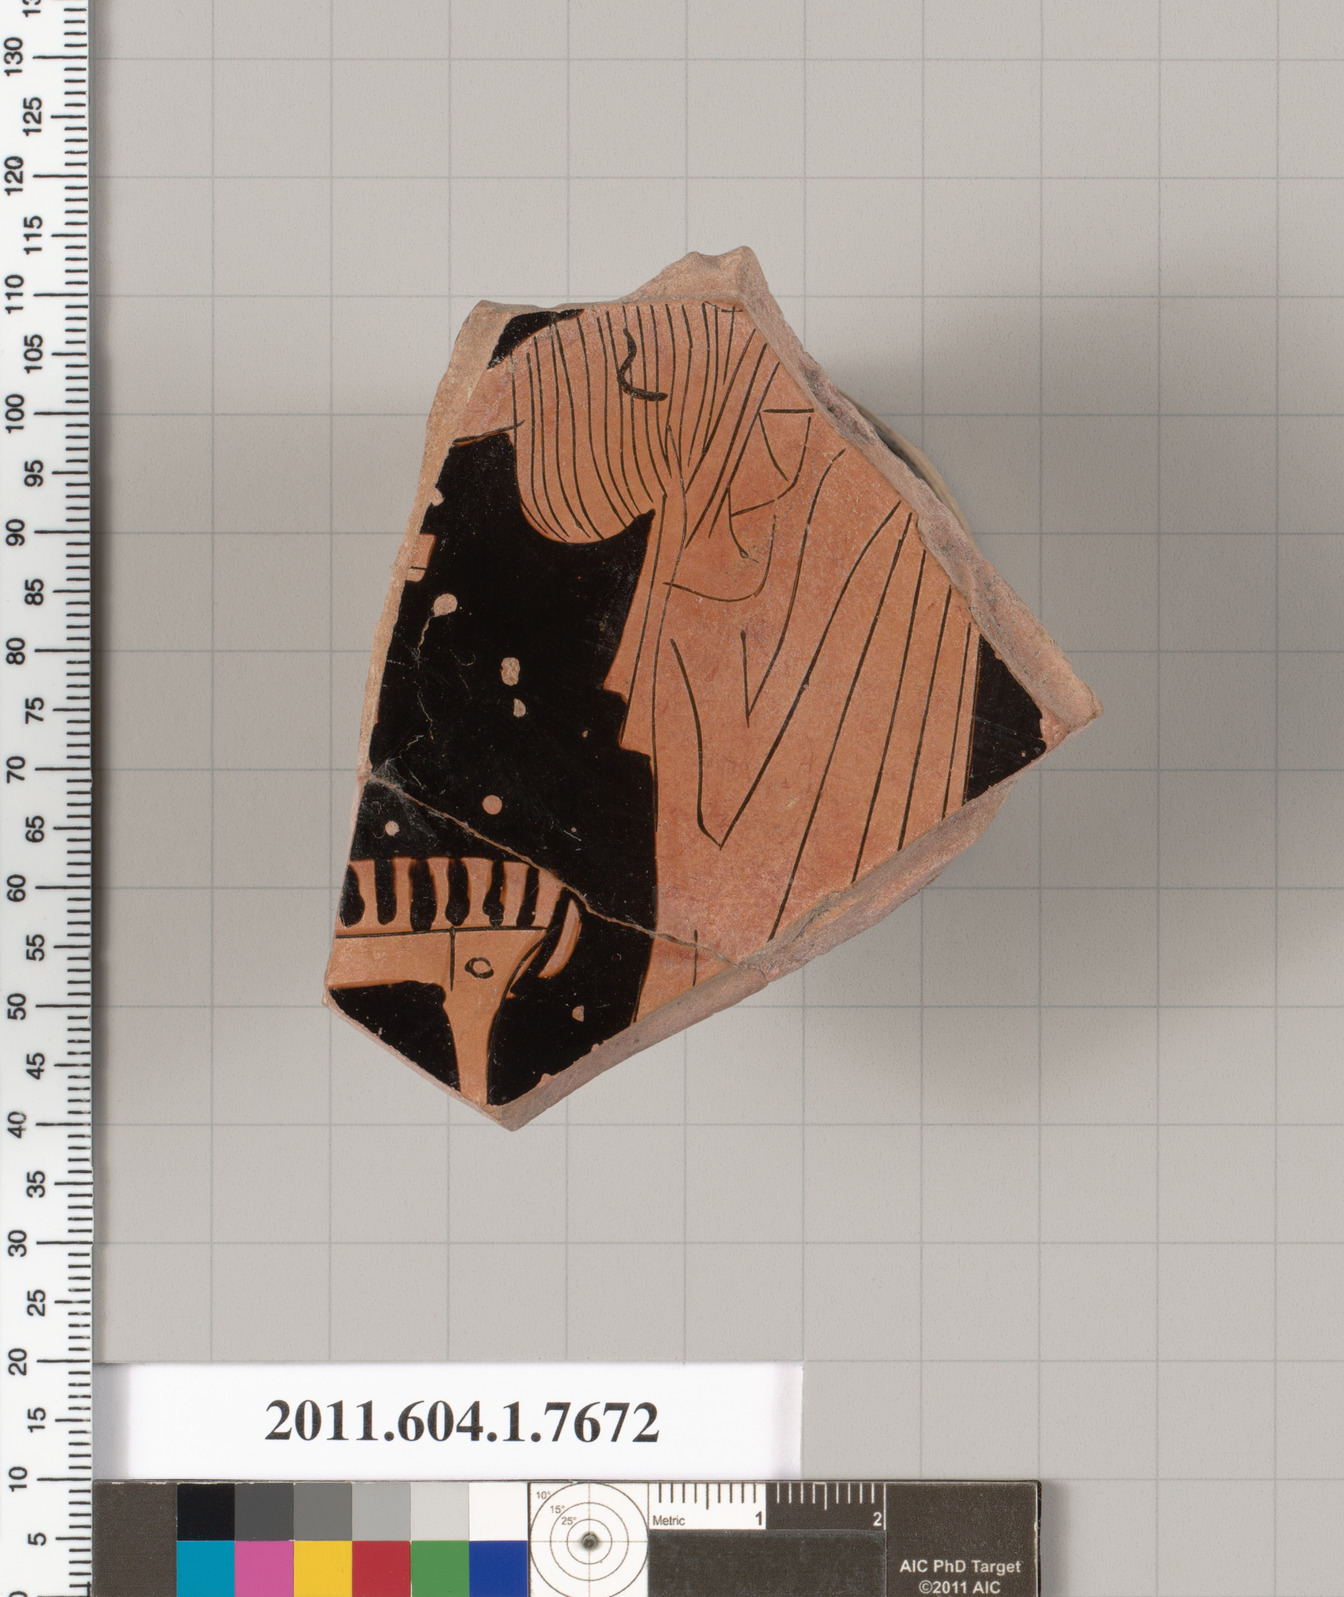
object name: kylix fragment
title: Terracotta fragment of a kylix (drinking cup)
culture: greek, attic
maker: stieglitz painter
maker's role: artist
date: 480-470 BCE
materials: terracotta